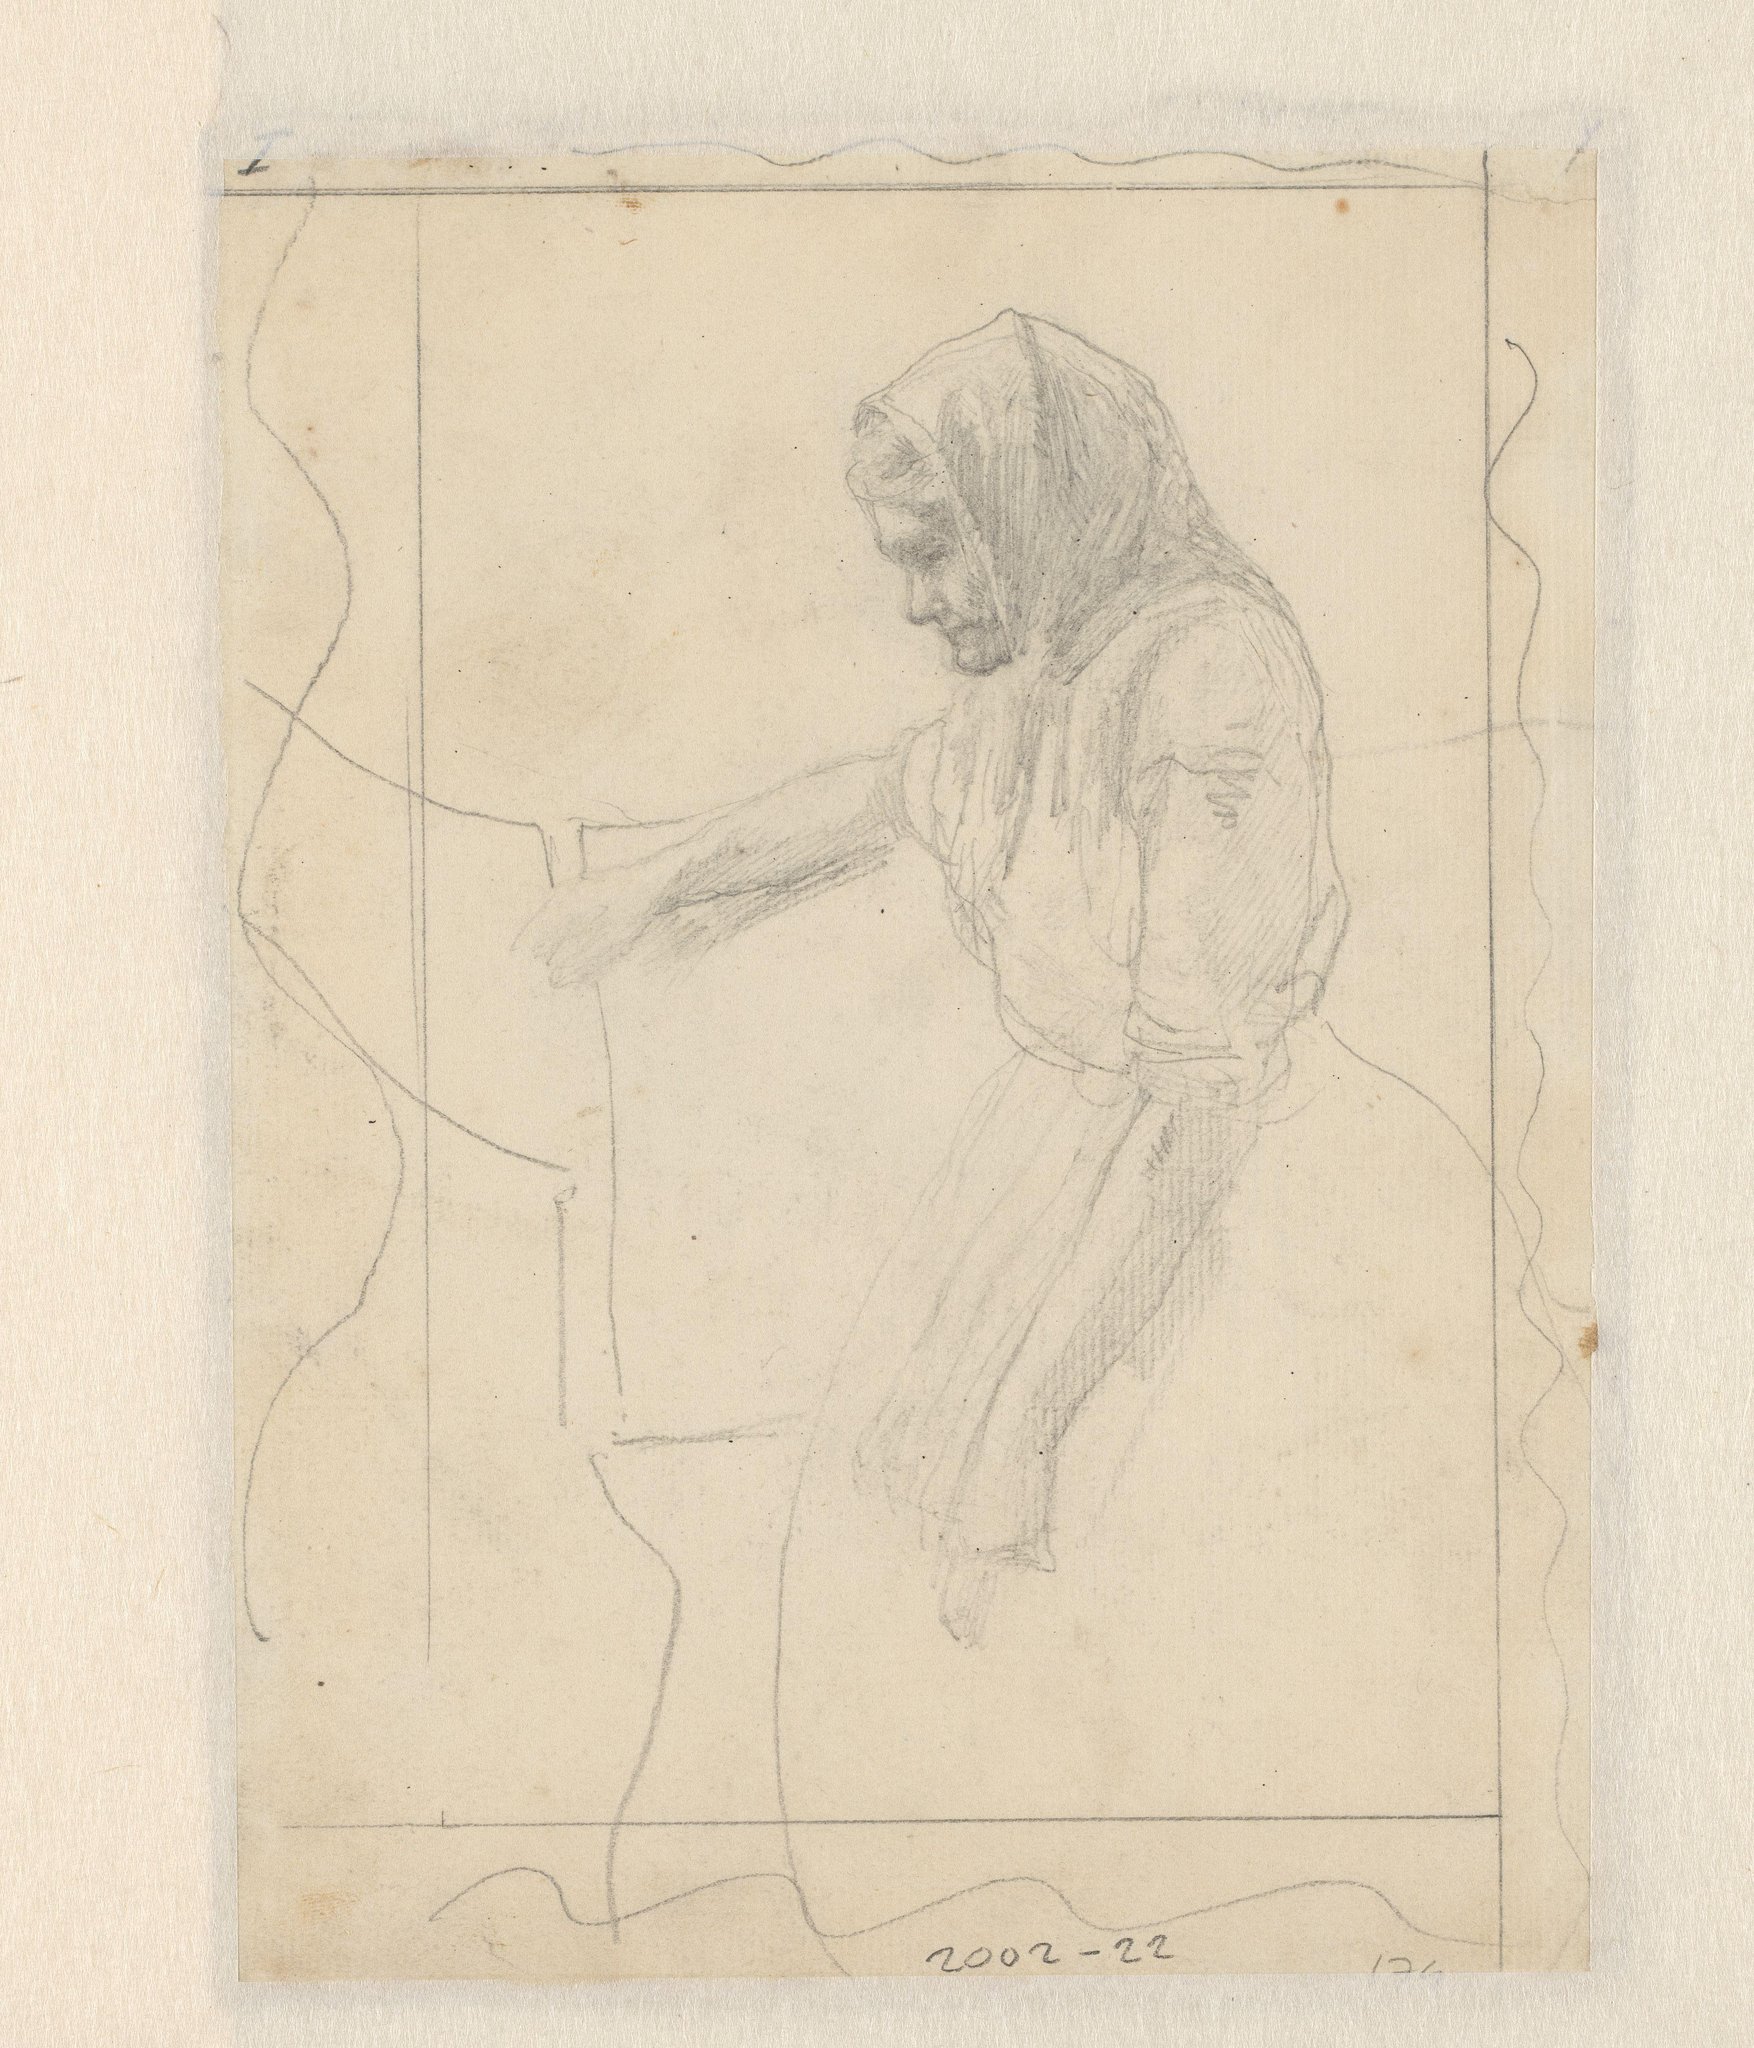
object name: drawing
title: Oude vrouw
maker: matthijs maris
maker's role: draughtsman, painter, print maker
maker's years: 1839-1917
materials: paper, pencil